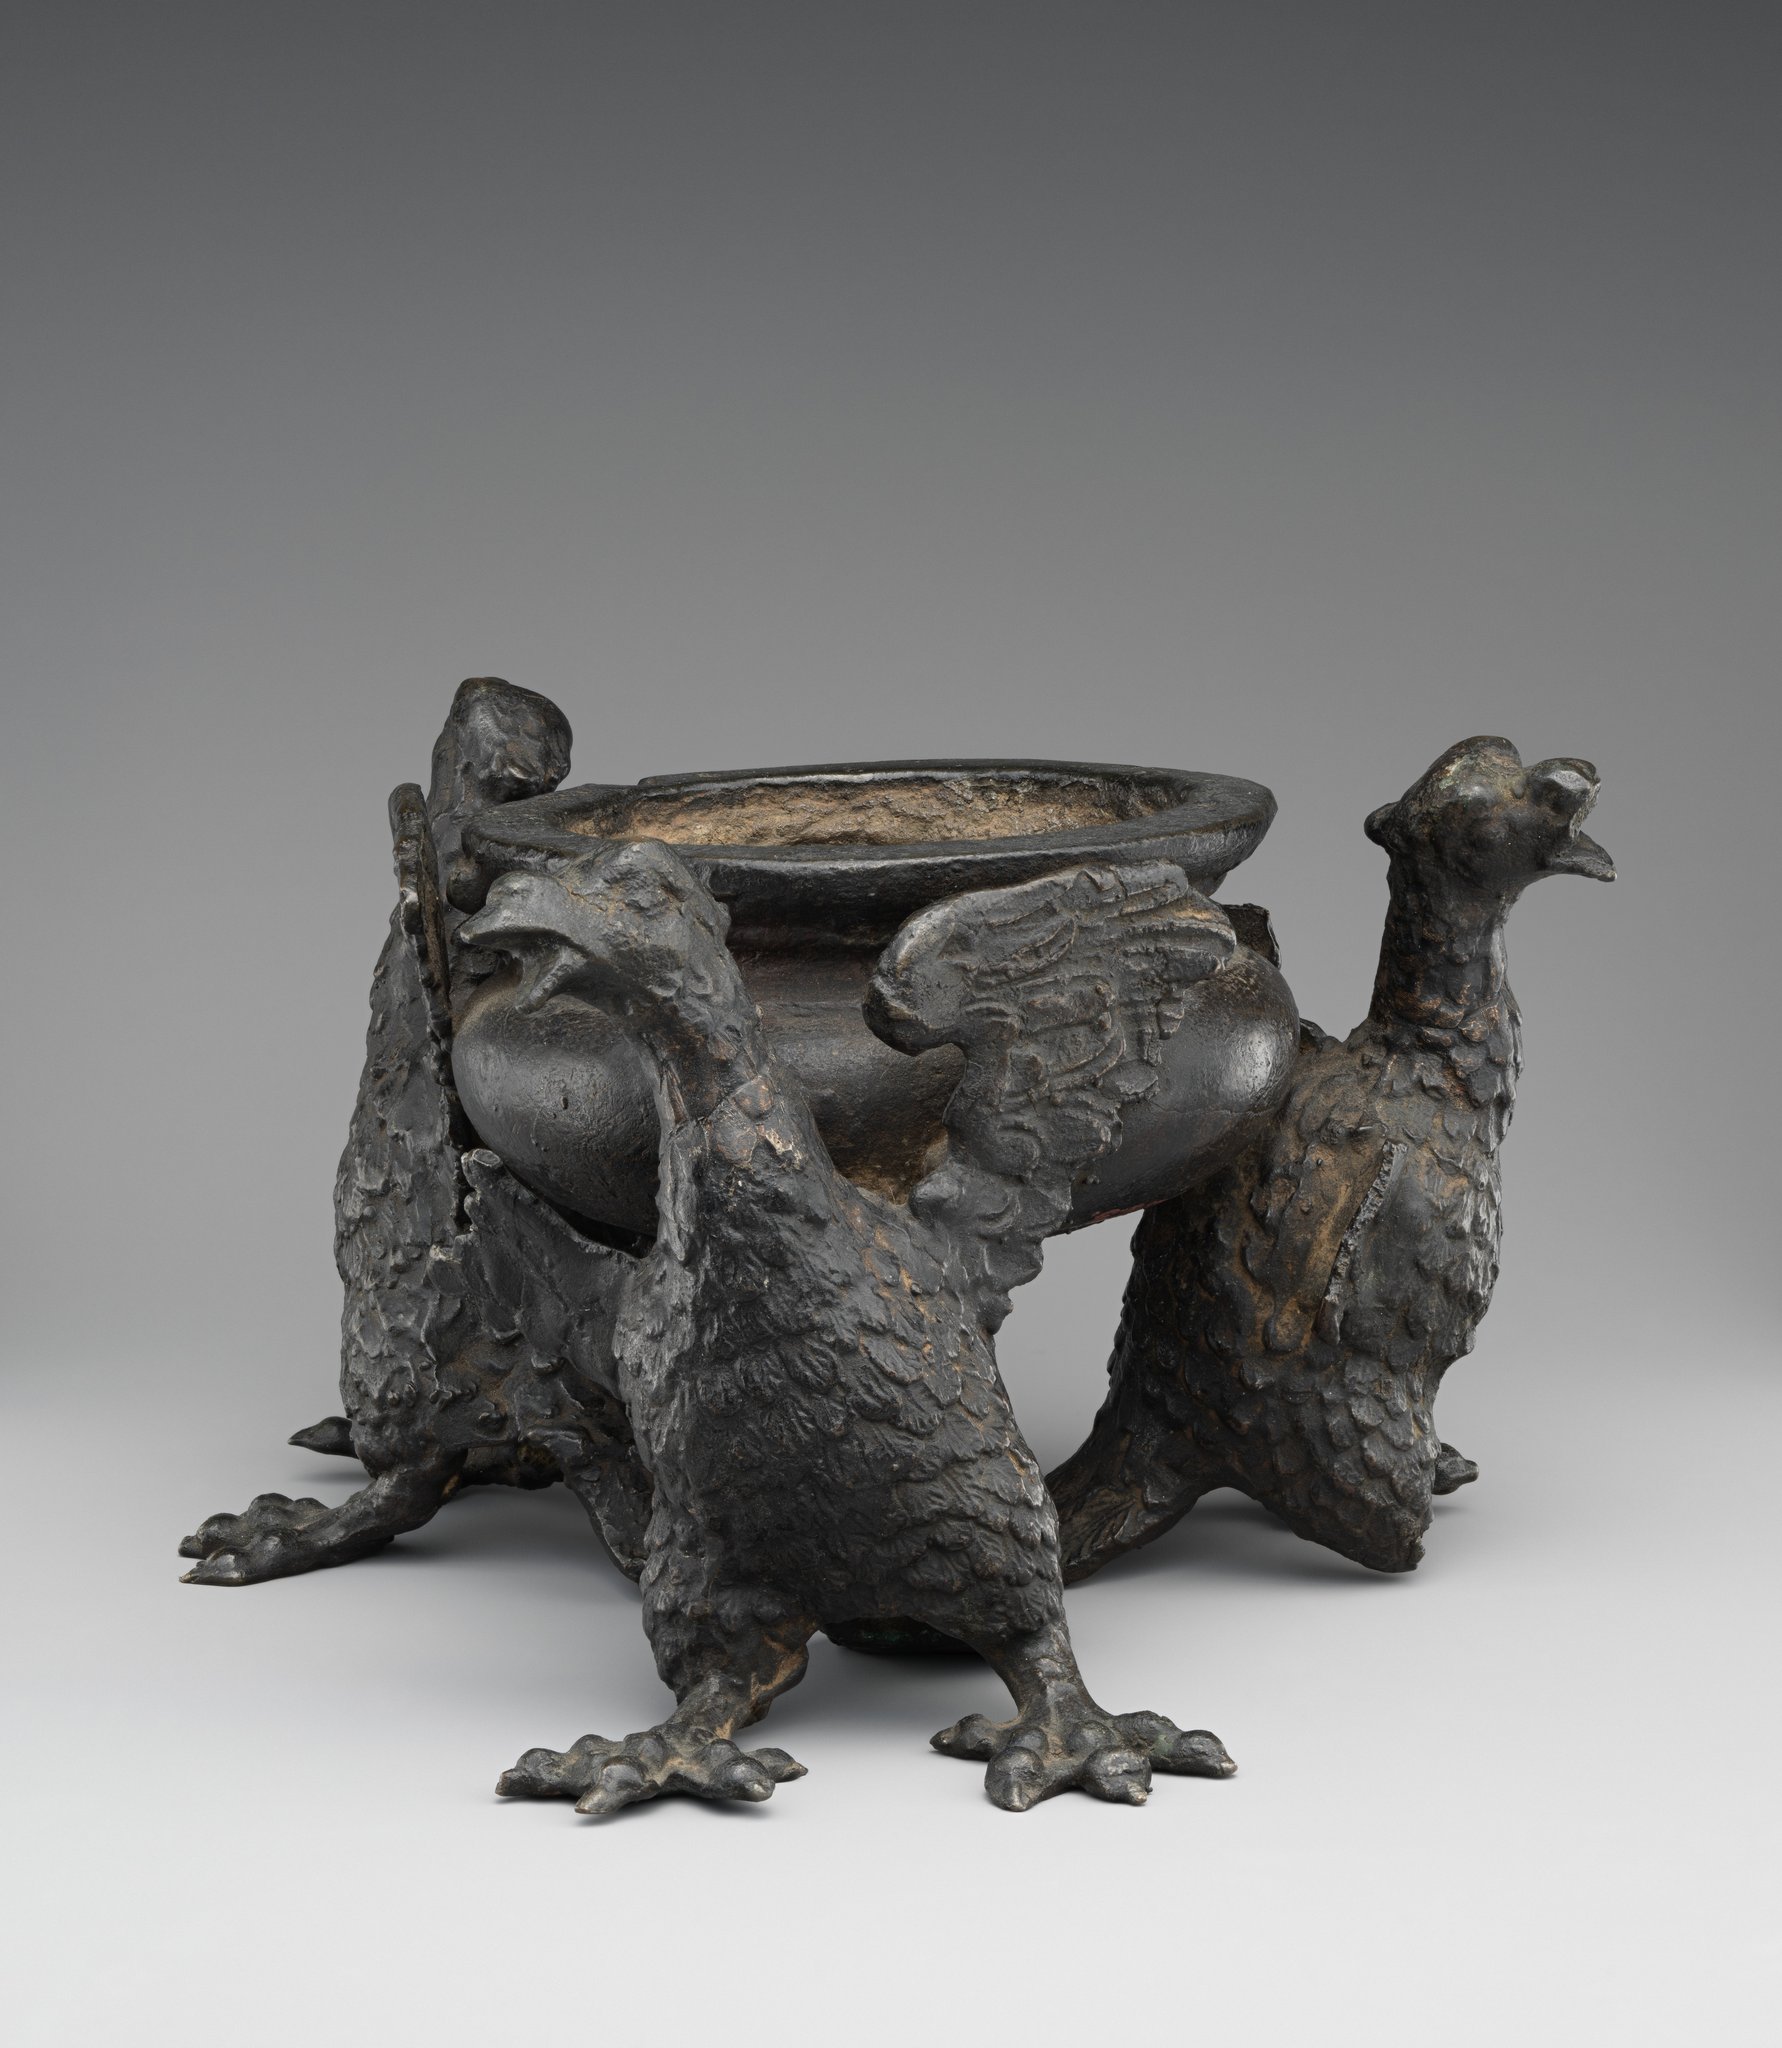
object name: inkstand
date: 1500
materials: bronze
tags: eagles